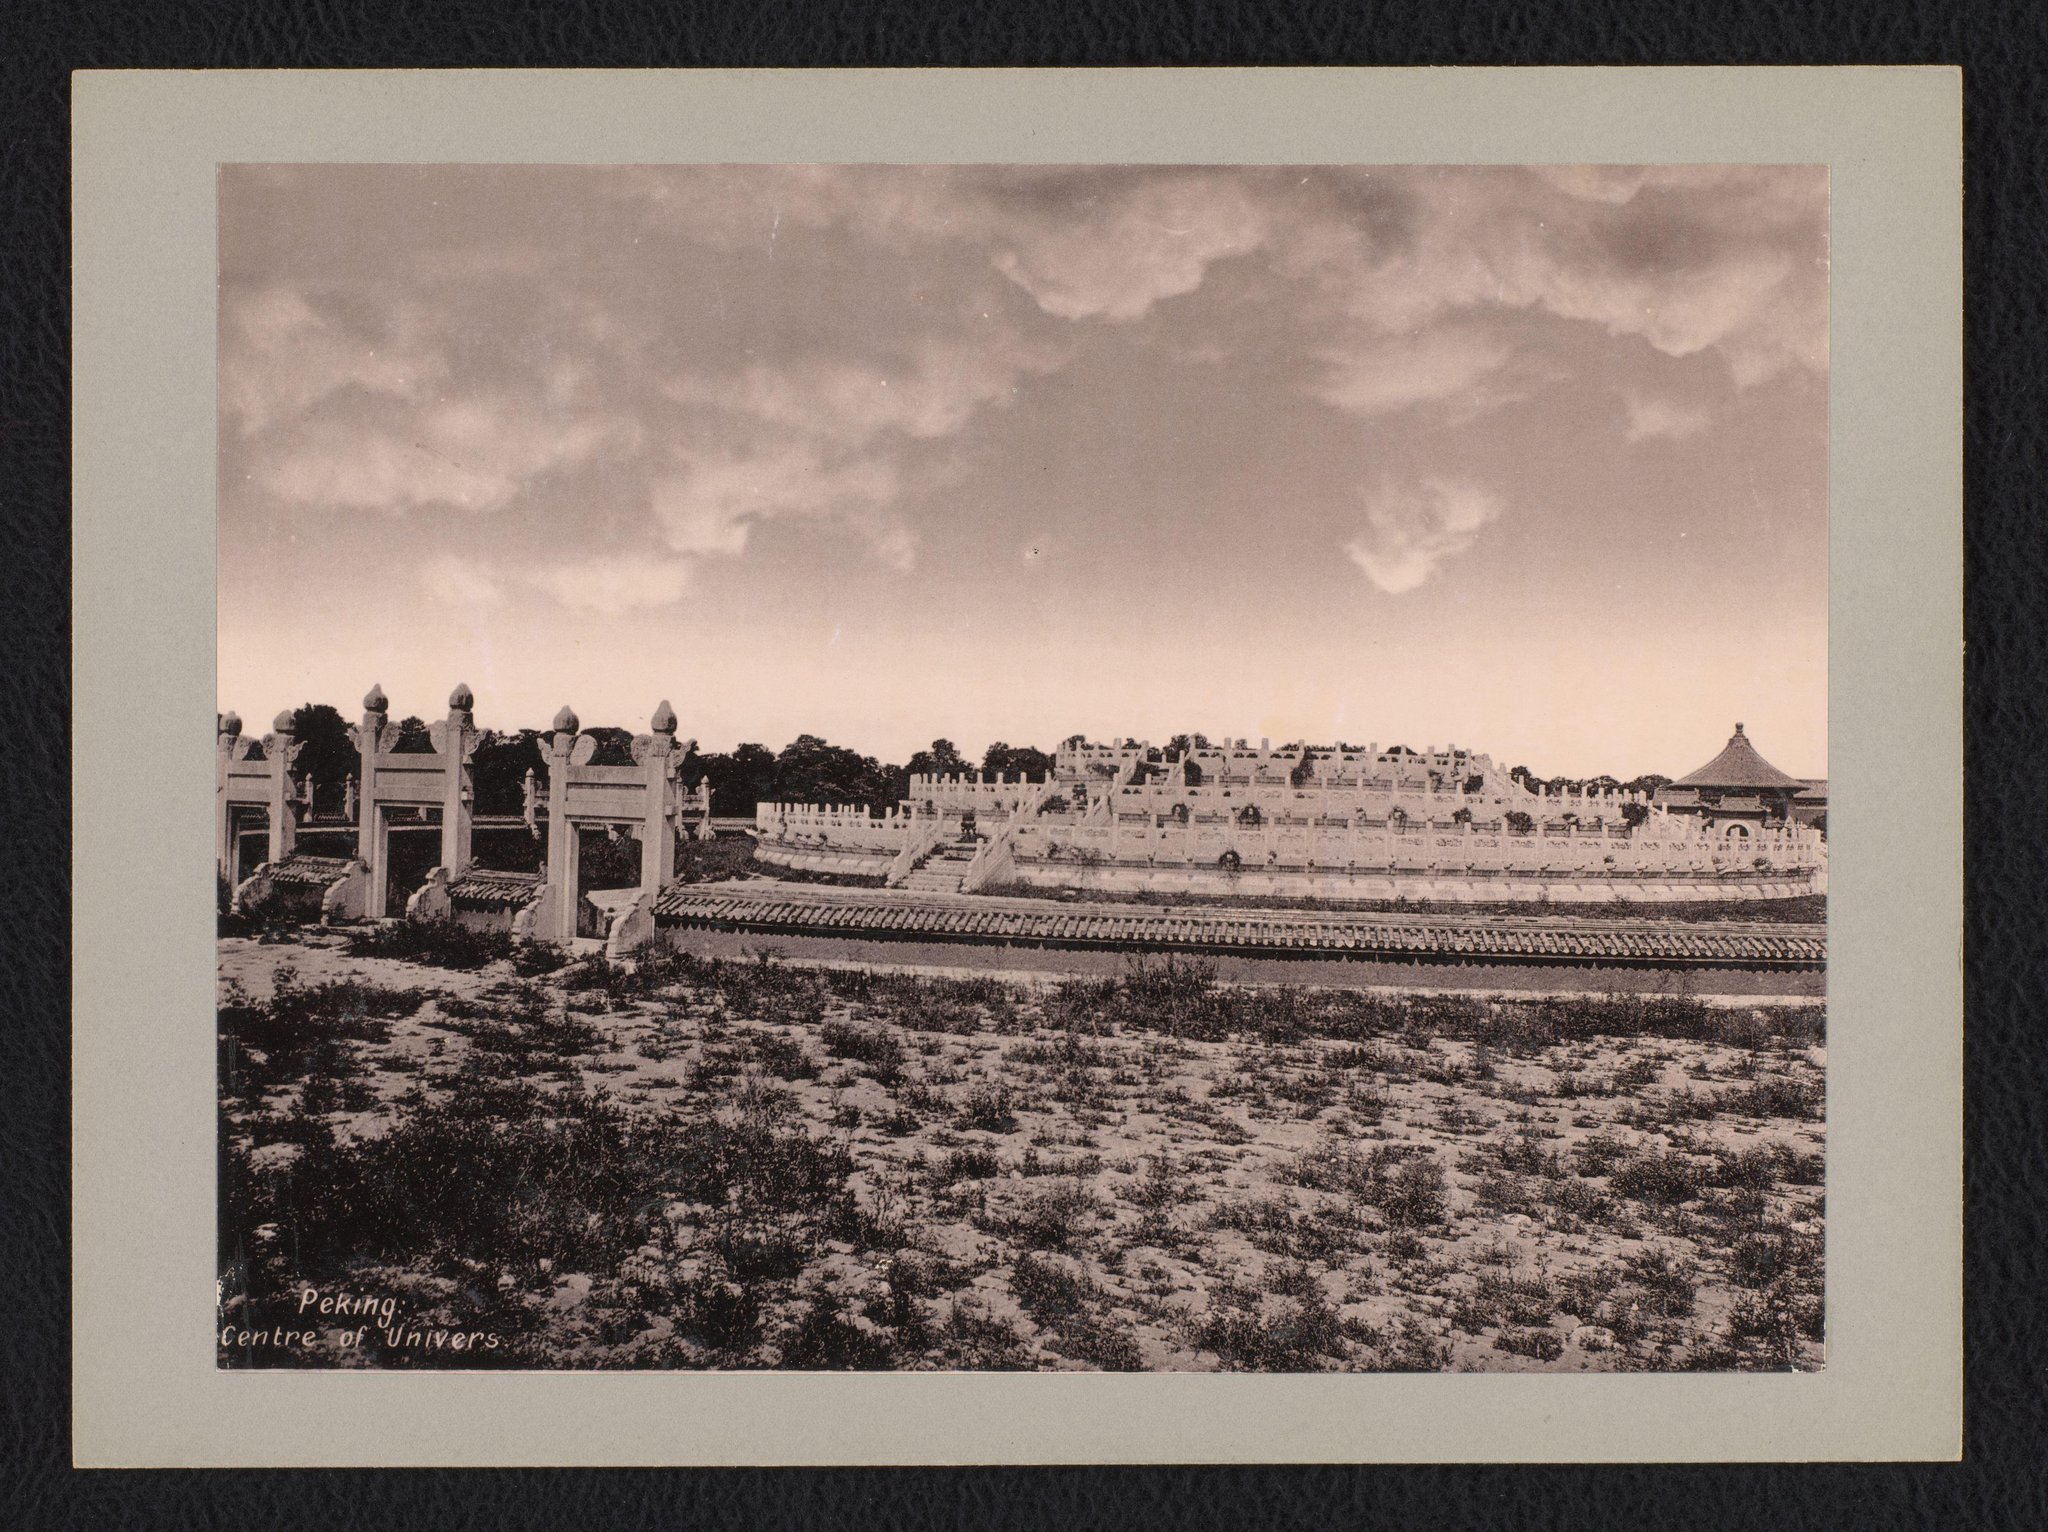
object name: photograph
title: Peking: Centre of Univers.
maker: Anonymous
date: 1895-1915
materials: cardboard, photographic support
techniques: photograph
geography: beijing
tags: peking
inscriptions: number: ‘3.’